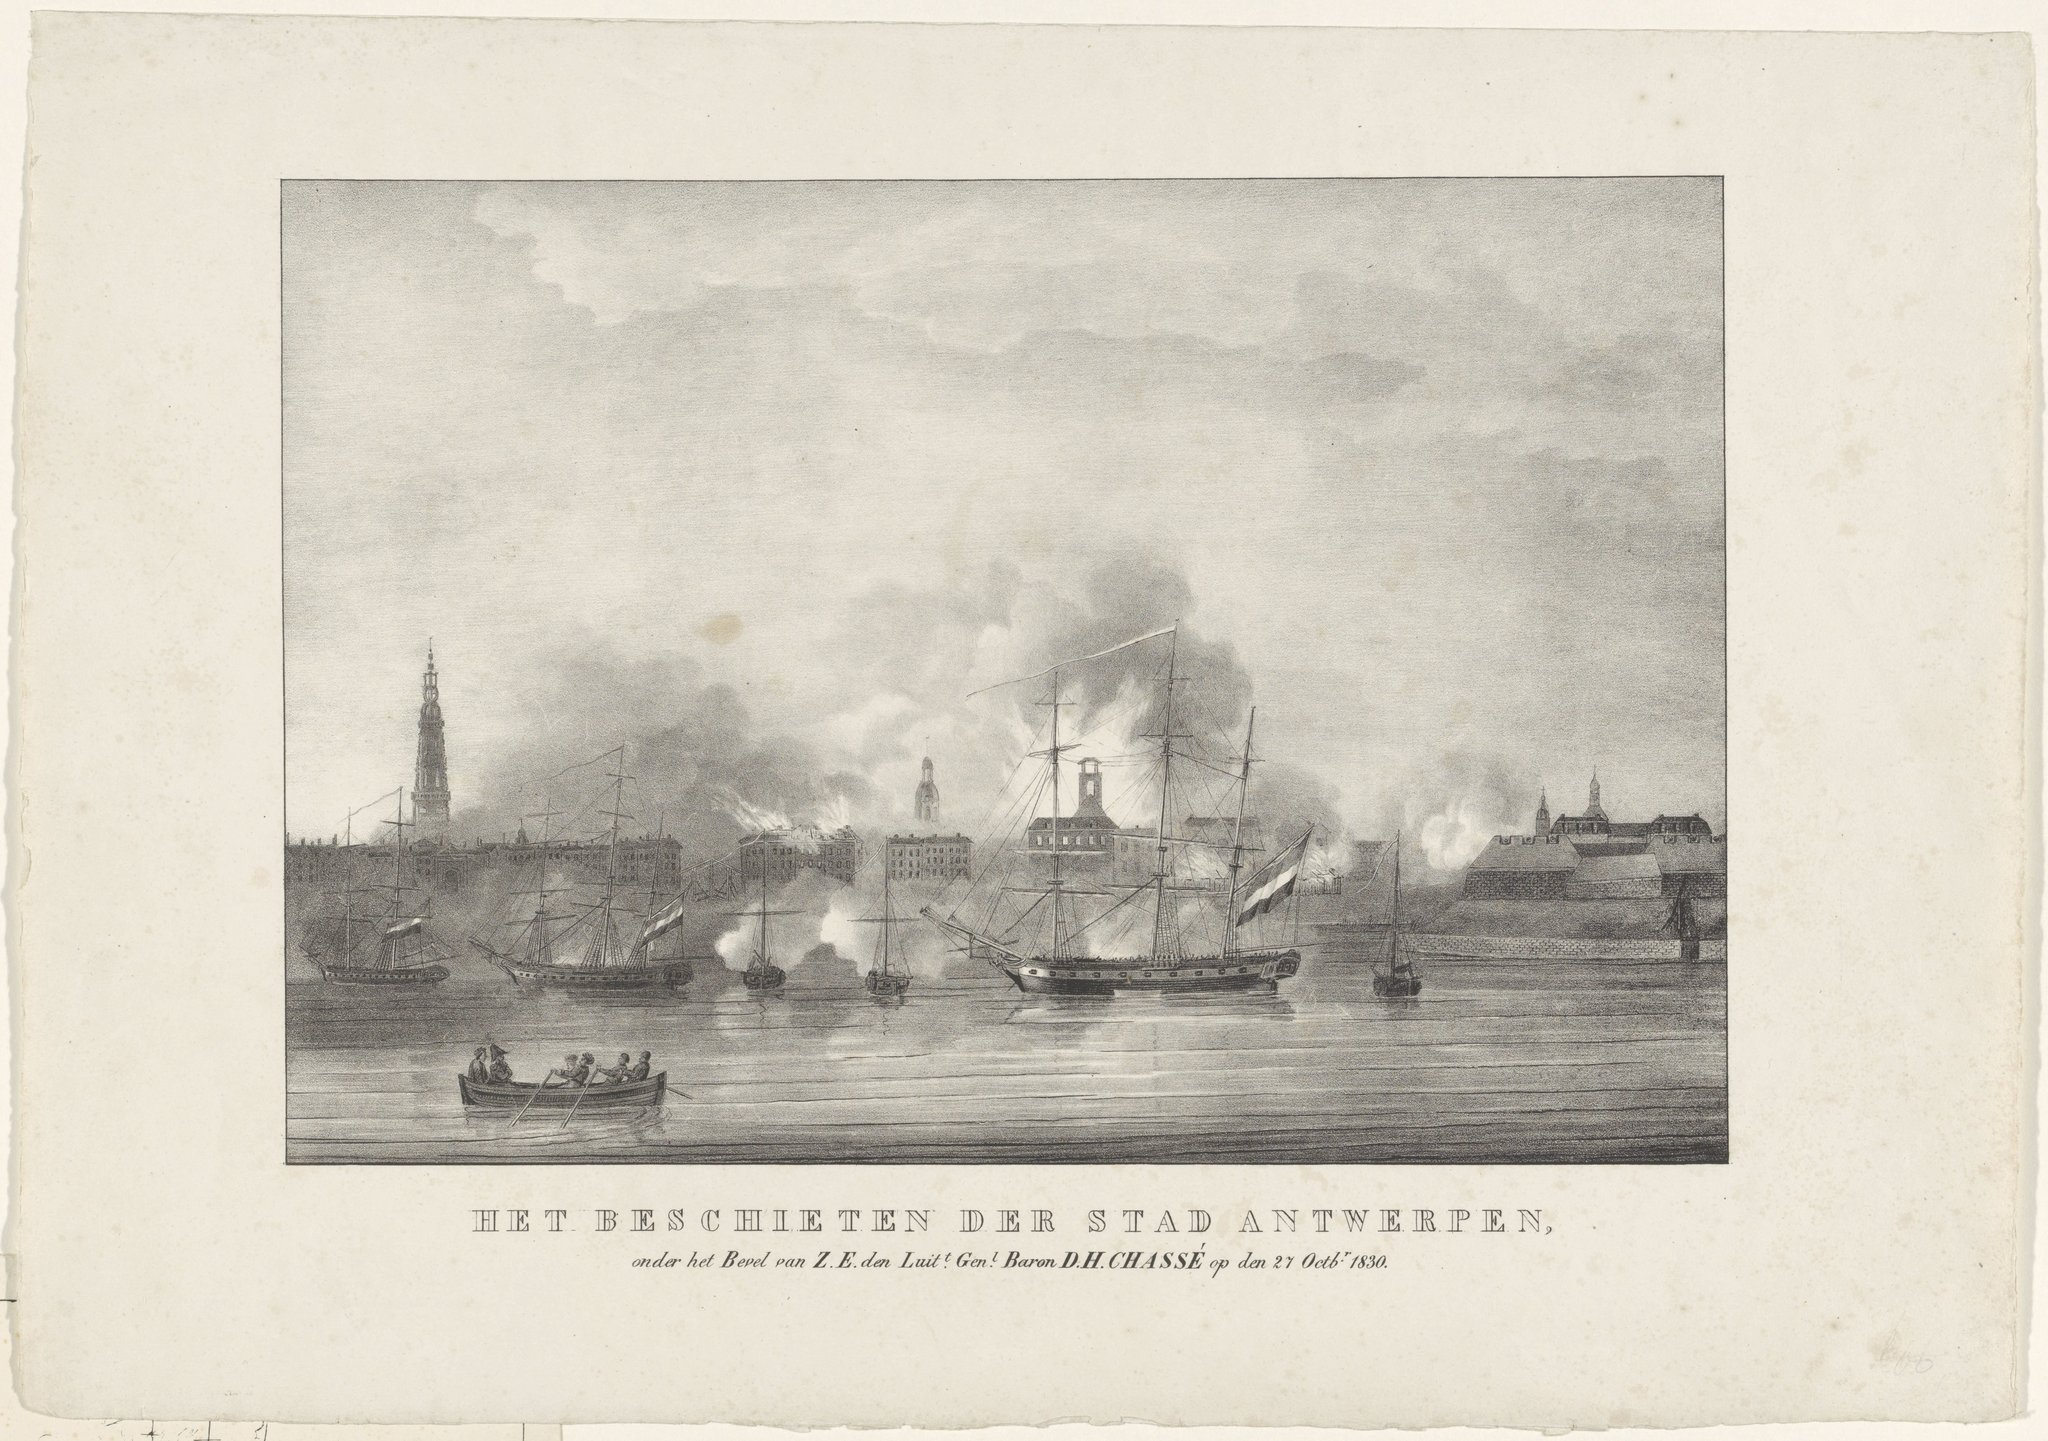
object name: print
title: Beschieting van Antwerpen, 1830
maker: Anonymous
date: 1830-1831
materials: paper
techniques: lithograph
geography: netherlands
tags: david hendrik baron chassé, bombardment ~ siege, bombardment, antwerp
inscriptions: collector's mark: Lugt 2228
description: Bombardement van Antwerpen door Nederlandse oorlogsschepen onder bevel van baron Chassé, op 27 oktober 1830. Op de Schelde de drie fregatten: de Gier, Comeet en Euridice en enkele kleinere boten. Bij de prent behoort een kleinere prent met de sleutel tot de voorstelling, met de namen van de schepen en belangrijkste gebouwen.